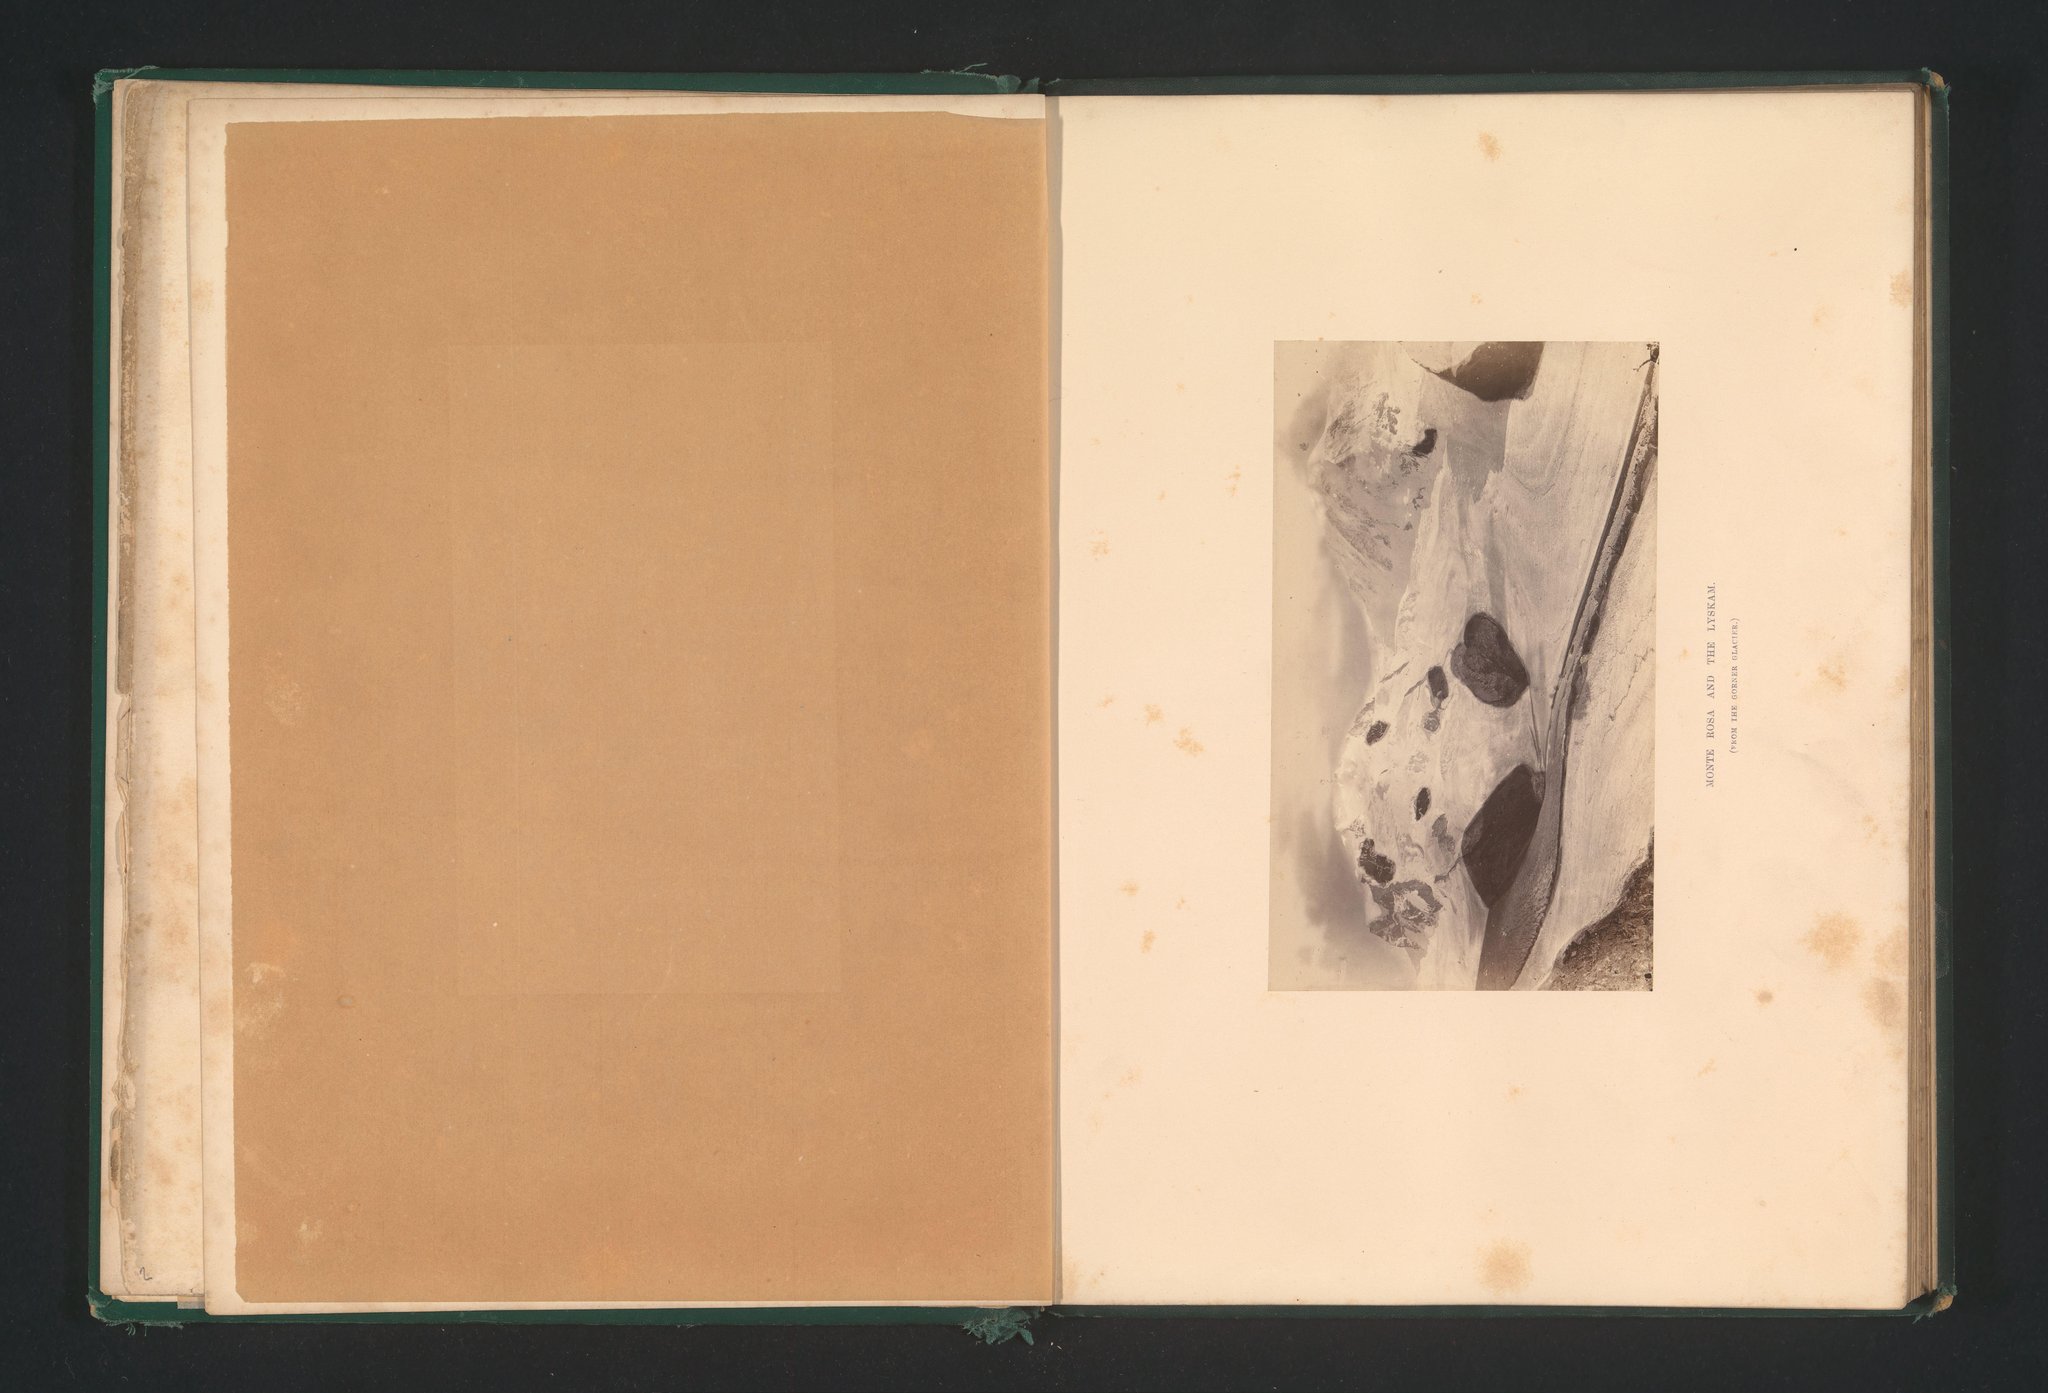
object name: page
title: Monte Rosa and the Lyskam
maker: stephen thompson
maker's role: fotograaf, schrijver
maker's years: 1831-1893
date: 1863-1868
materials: photographic support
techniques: albumen print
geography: monte rosa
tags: glacier, mountain-range, snow peaks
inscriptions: inscription: ‘(from the corner glacier)’